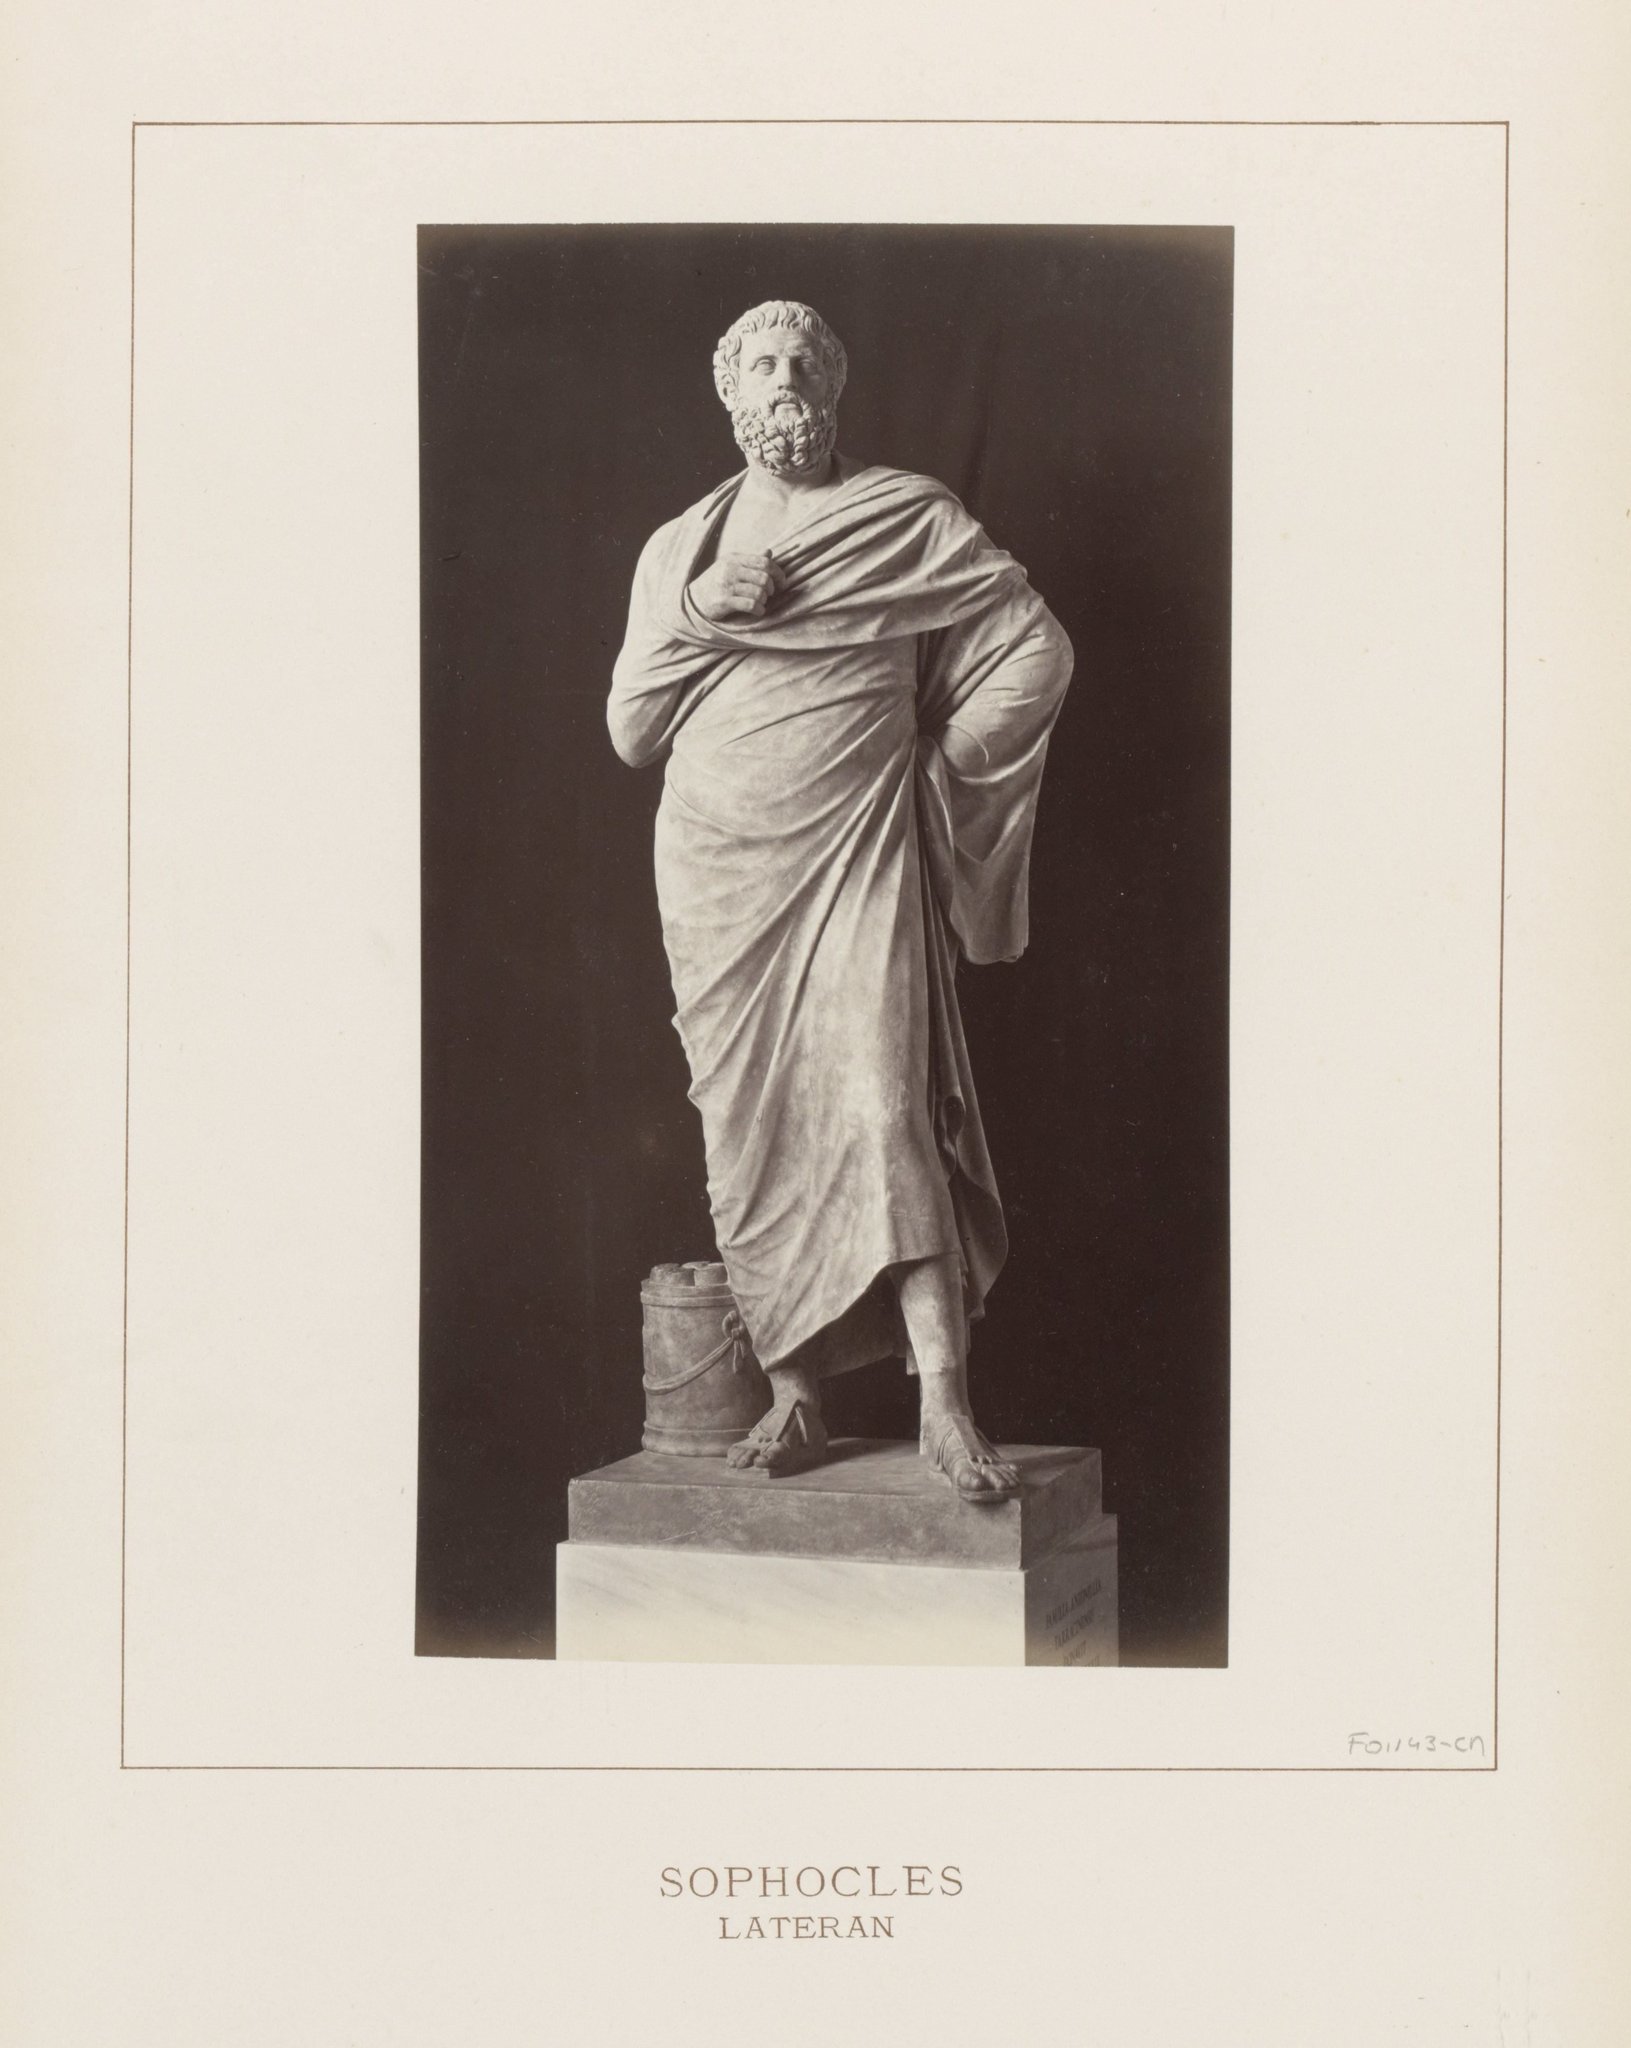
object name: photograph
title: Beeldhouwwerk Sophocles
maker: Anonymous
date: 1860-1900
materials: photographic support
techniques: albumen print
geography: vatican city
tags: sophocles, piece of sculpture, reproduction of a piece of sculpture, writer, poet, author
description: Onderdeel van Fotoalbum met opnames van bezienswaardigheden en kunstwerken in Rome.